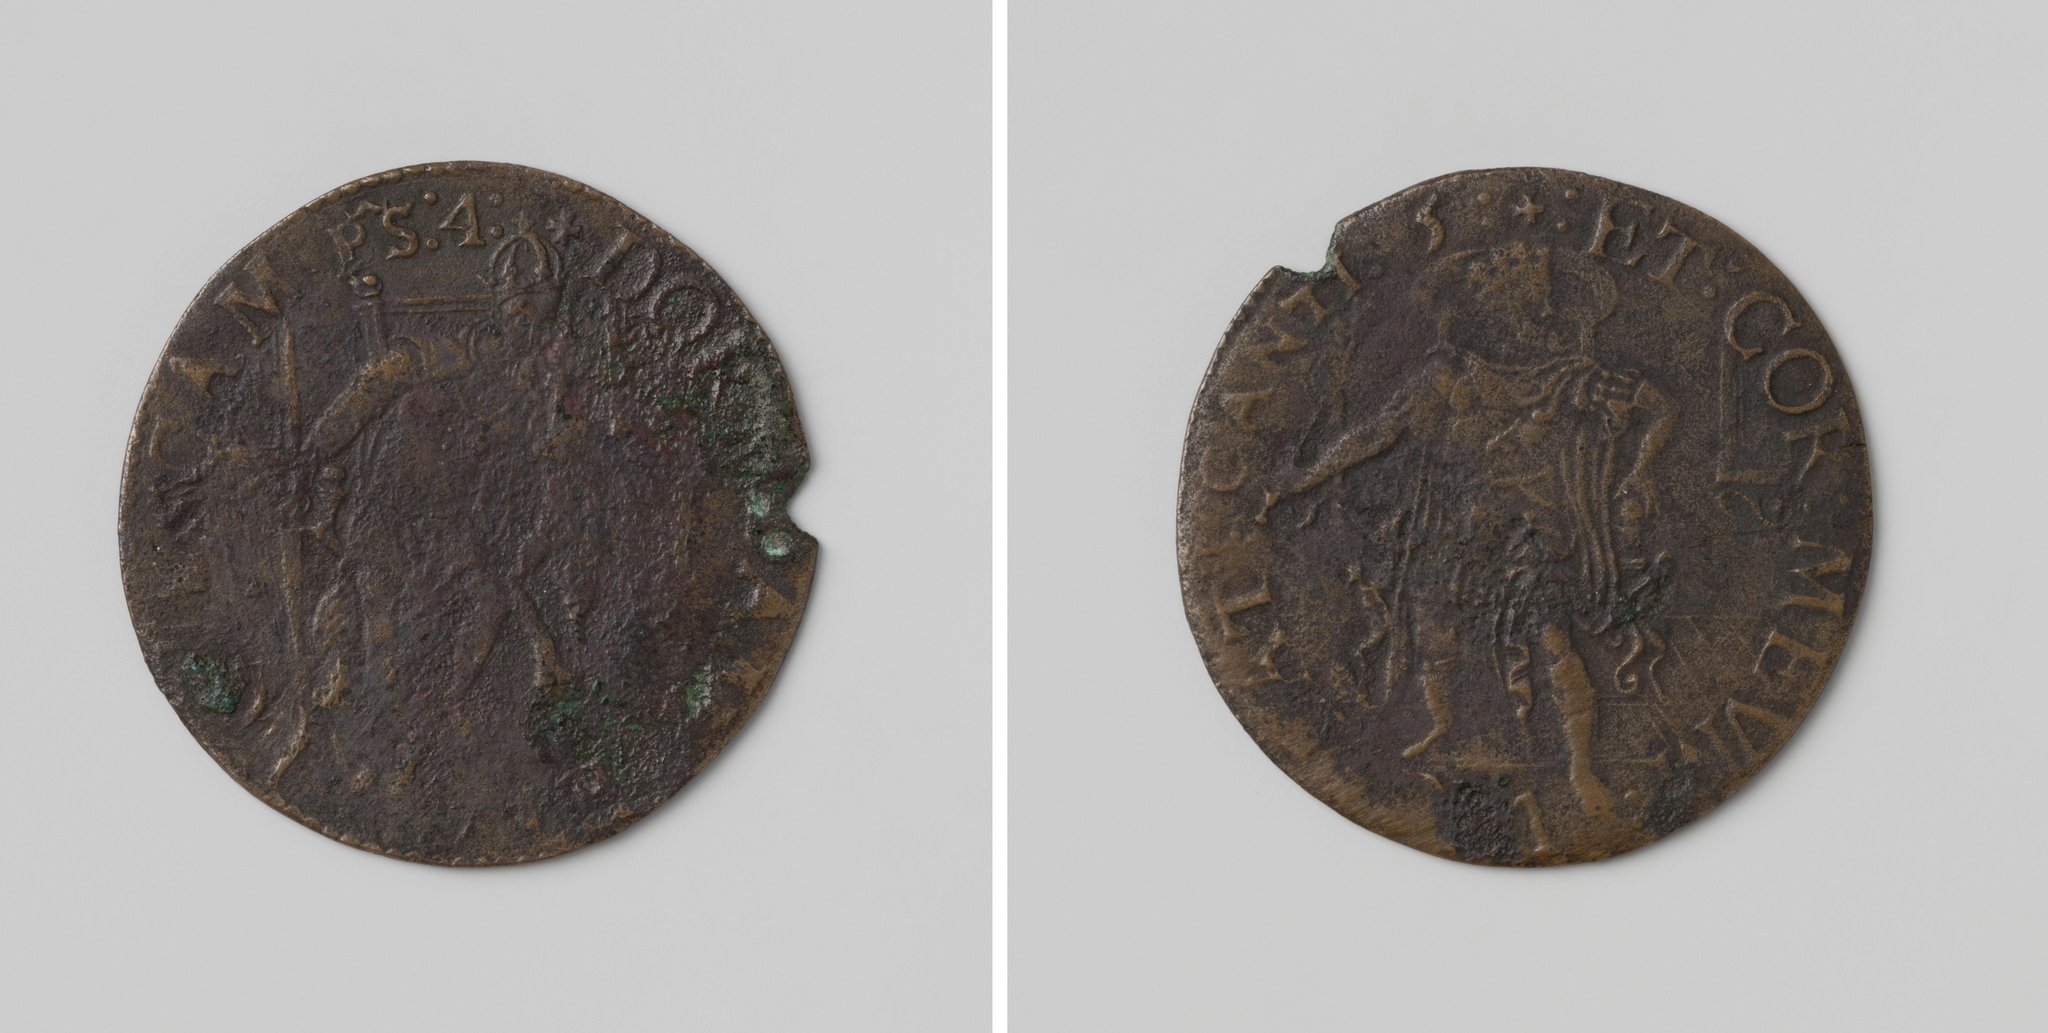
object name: jeton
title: Waakzaamheid van Karel V, Duits keizer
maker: Anonymous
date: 1544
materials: copper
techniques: striking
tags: charles v (holy roman emperor and king of spain)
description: Koperen penning. Voorzijde: portret Karel V, met zwaard in rechterhand slapend op stoel binnen omschrift. Keerzijde: portret van Karel V, met scepter in rechterhand opgestaan uit stoel binnen omschrift